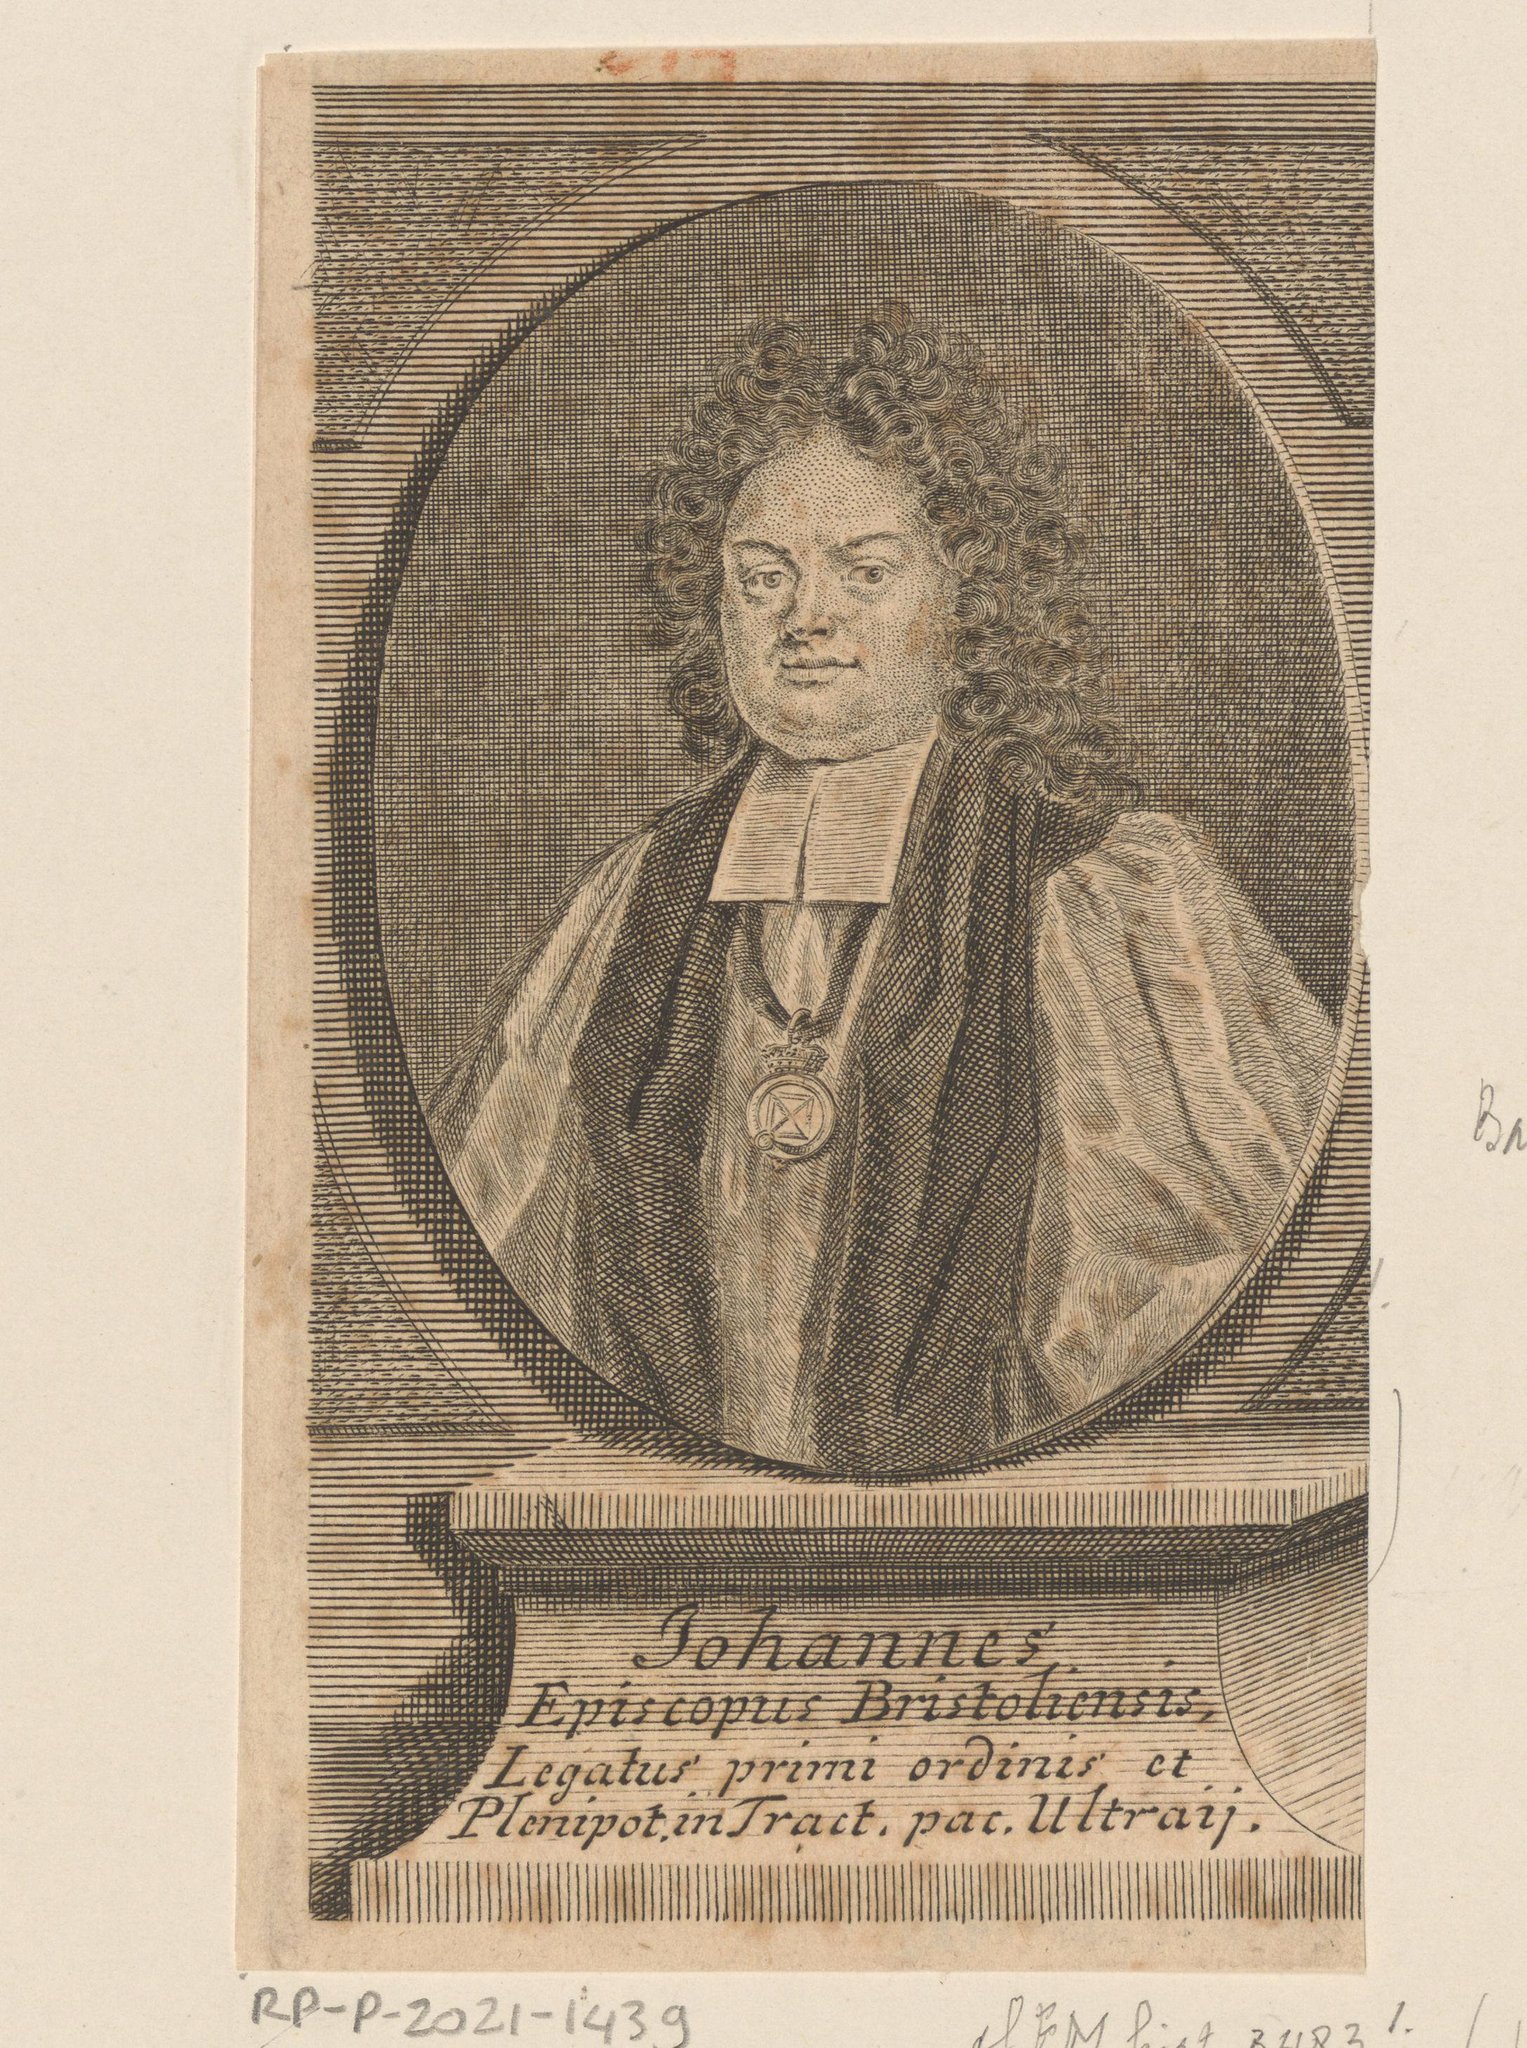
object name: print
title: Portret van bischop John Robinson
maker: martin bernigeroth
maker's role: print maker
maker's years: 1670-1733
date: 1710-1733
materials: paper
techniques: engraving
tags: historical persons, functionaries and dignitaries ~ episcopal protestant churches